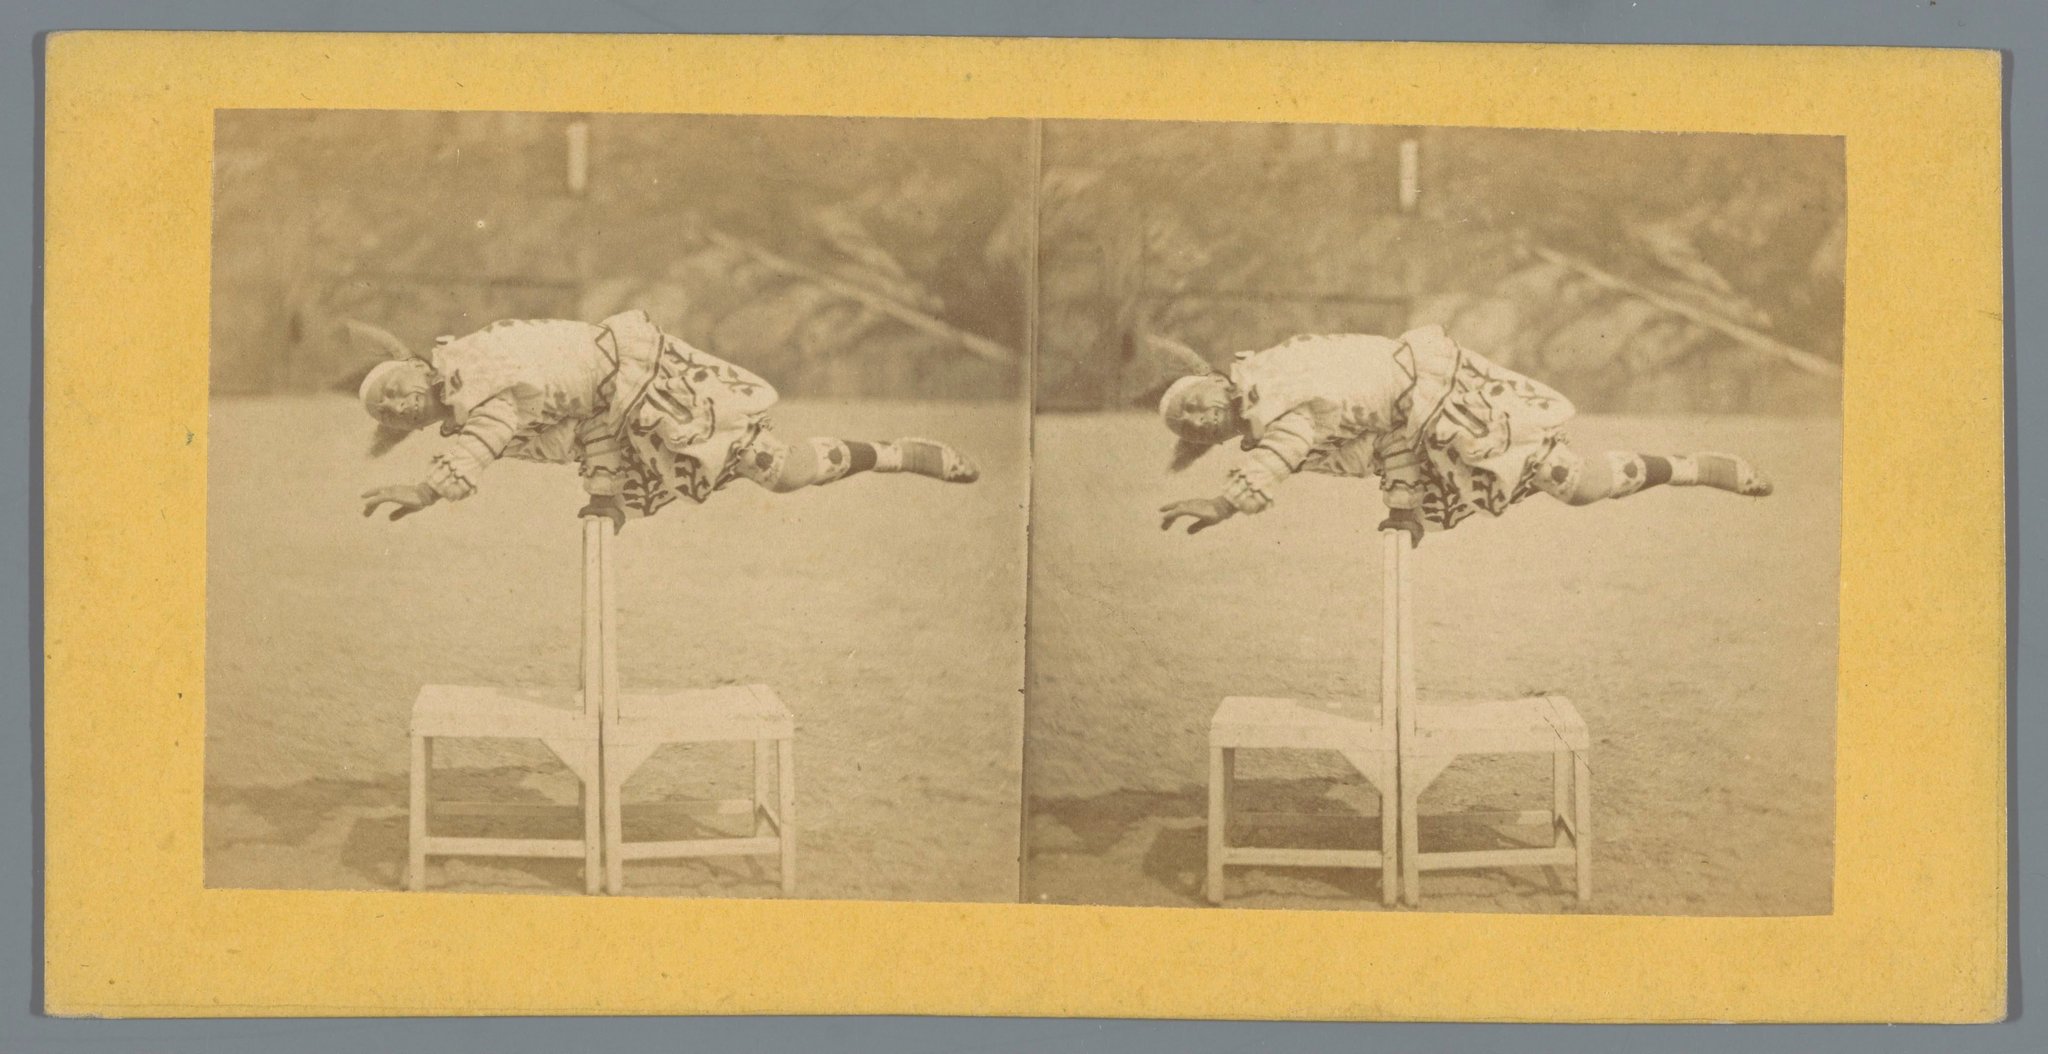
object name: stereograph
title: Clown die balanceert op stoelen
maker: Anonymous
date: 1850-1880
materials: cardboard, photographic support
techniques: albumen print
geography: europe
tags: clown, europe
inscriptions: number: ‘17814’